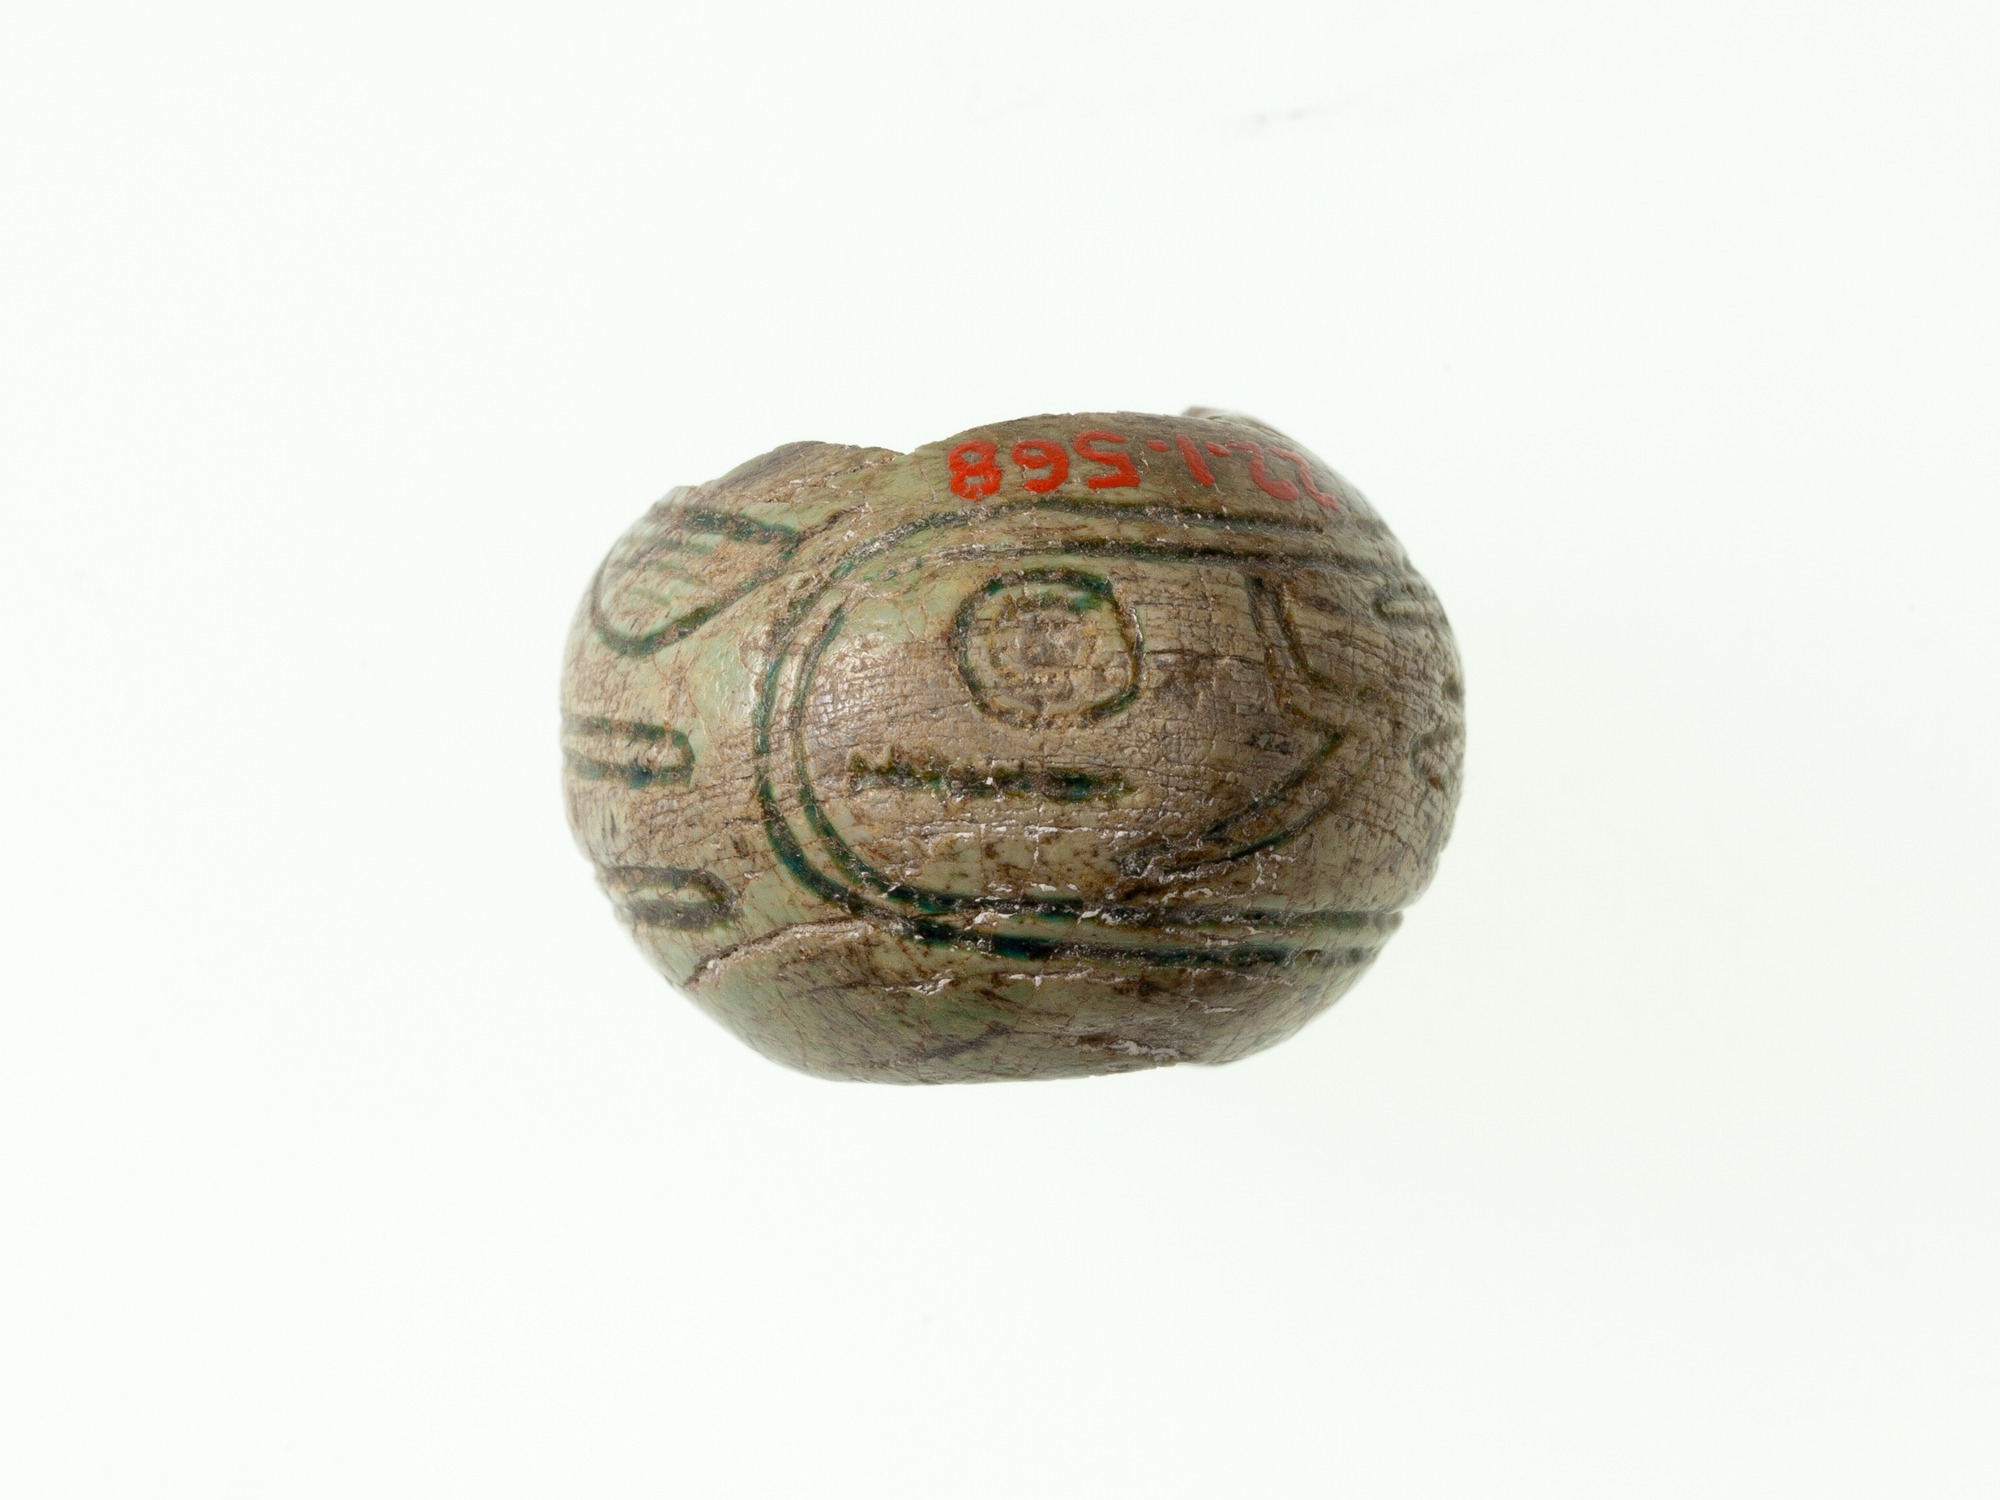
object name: bead, amenemhat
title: Bead with the name of Amenemhat III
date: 1859-1813 BCE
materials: stone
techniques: glazing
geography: egypt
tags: hieroglyphs